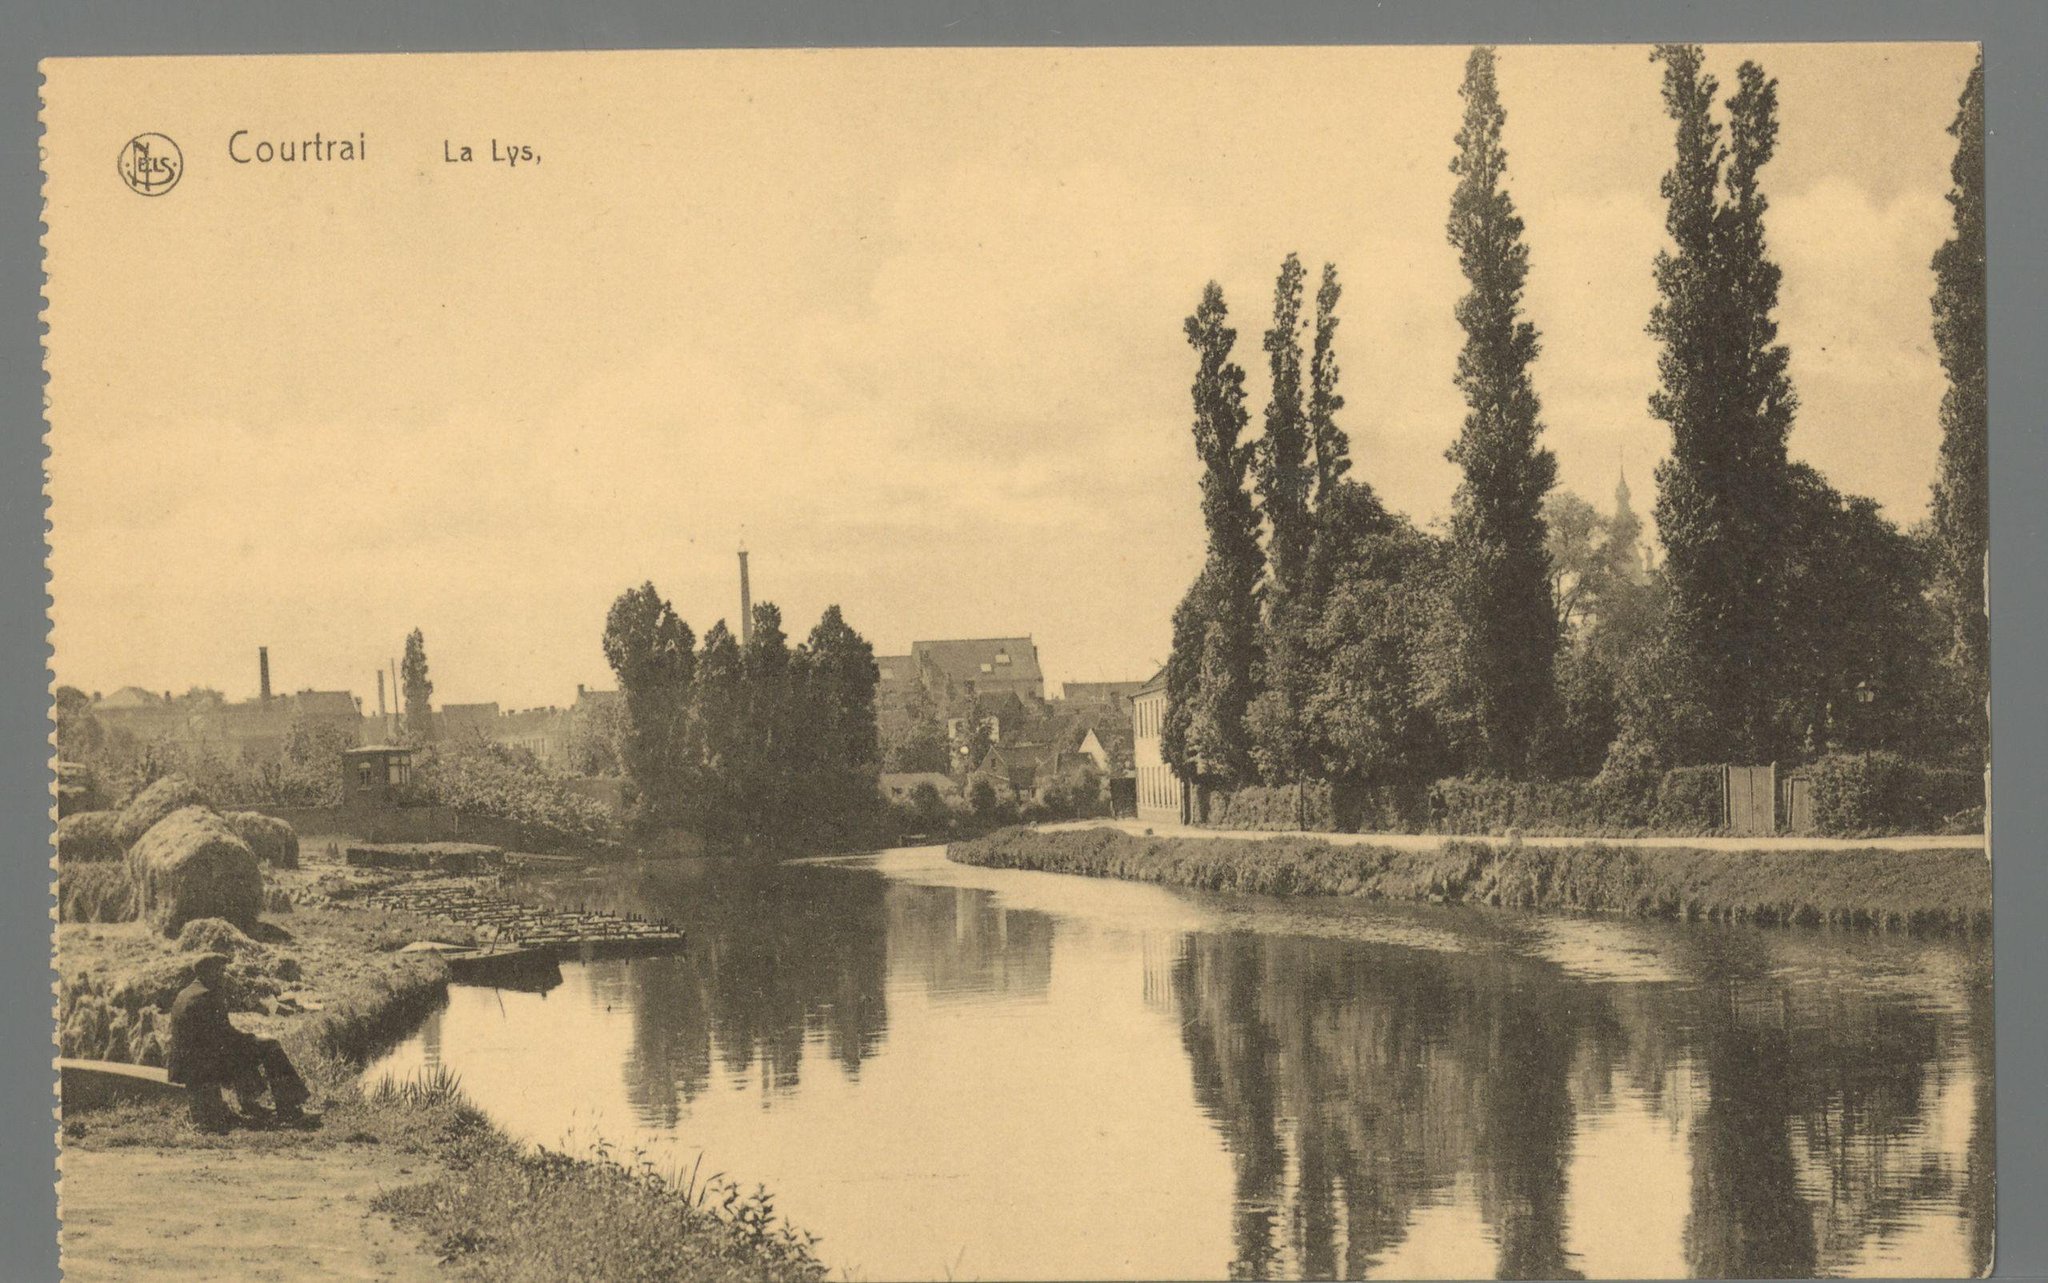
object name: ansichtkaart, prentbriefkaart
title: Courtrai. La Lys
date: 1913-1930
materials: cardboard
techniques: photograph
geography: brussels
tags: river (+ landscape with figures, staffage)